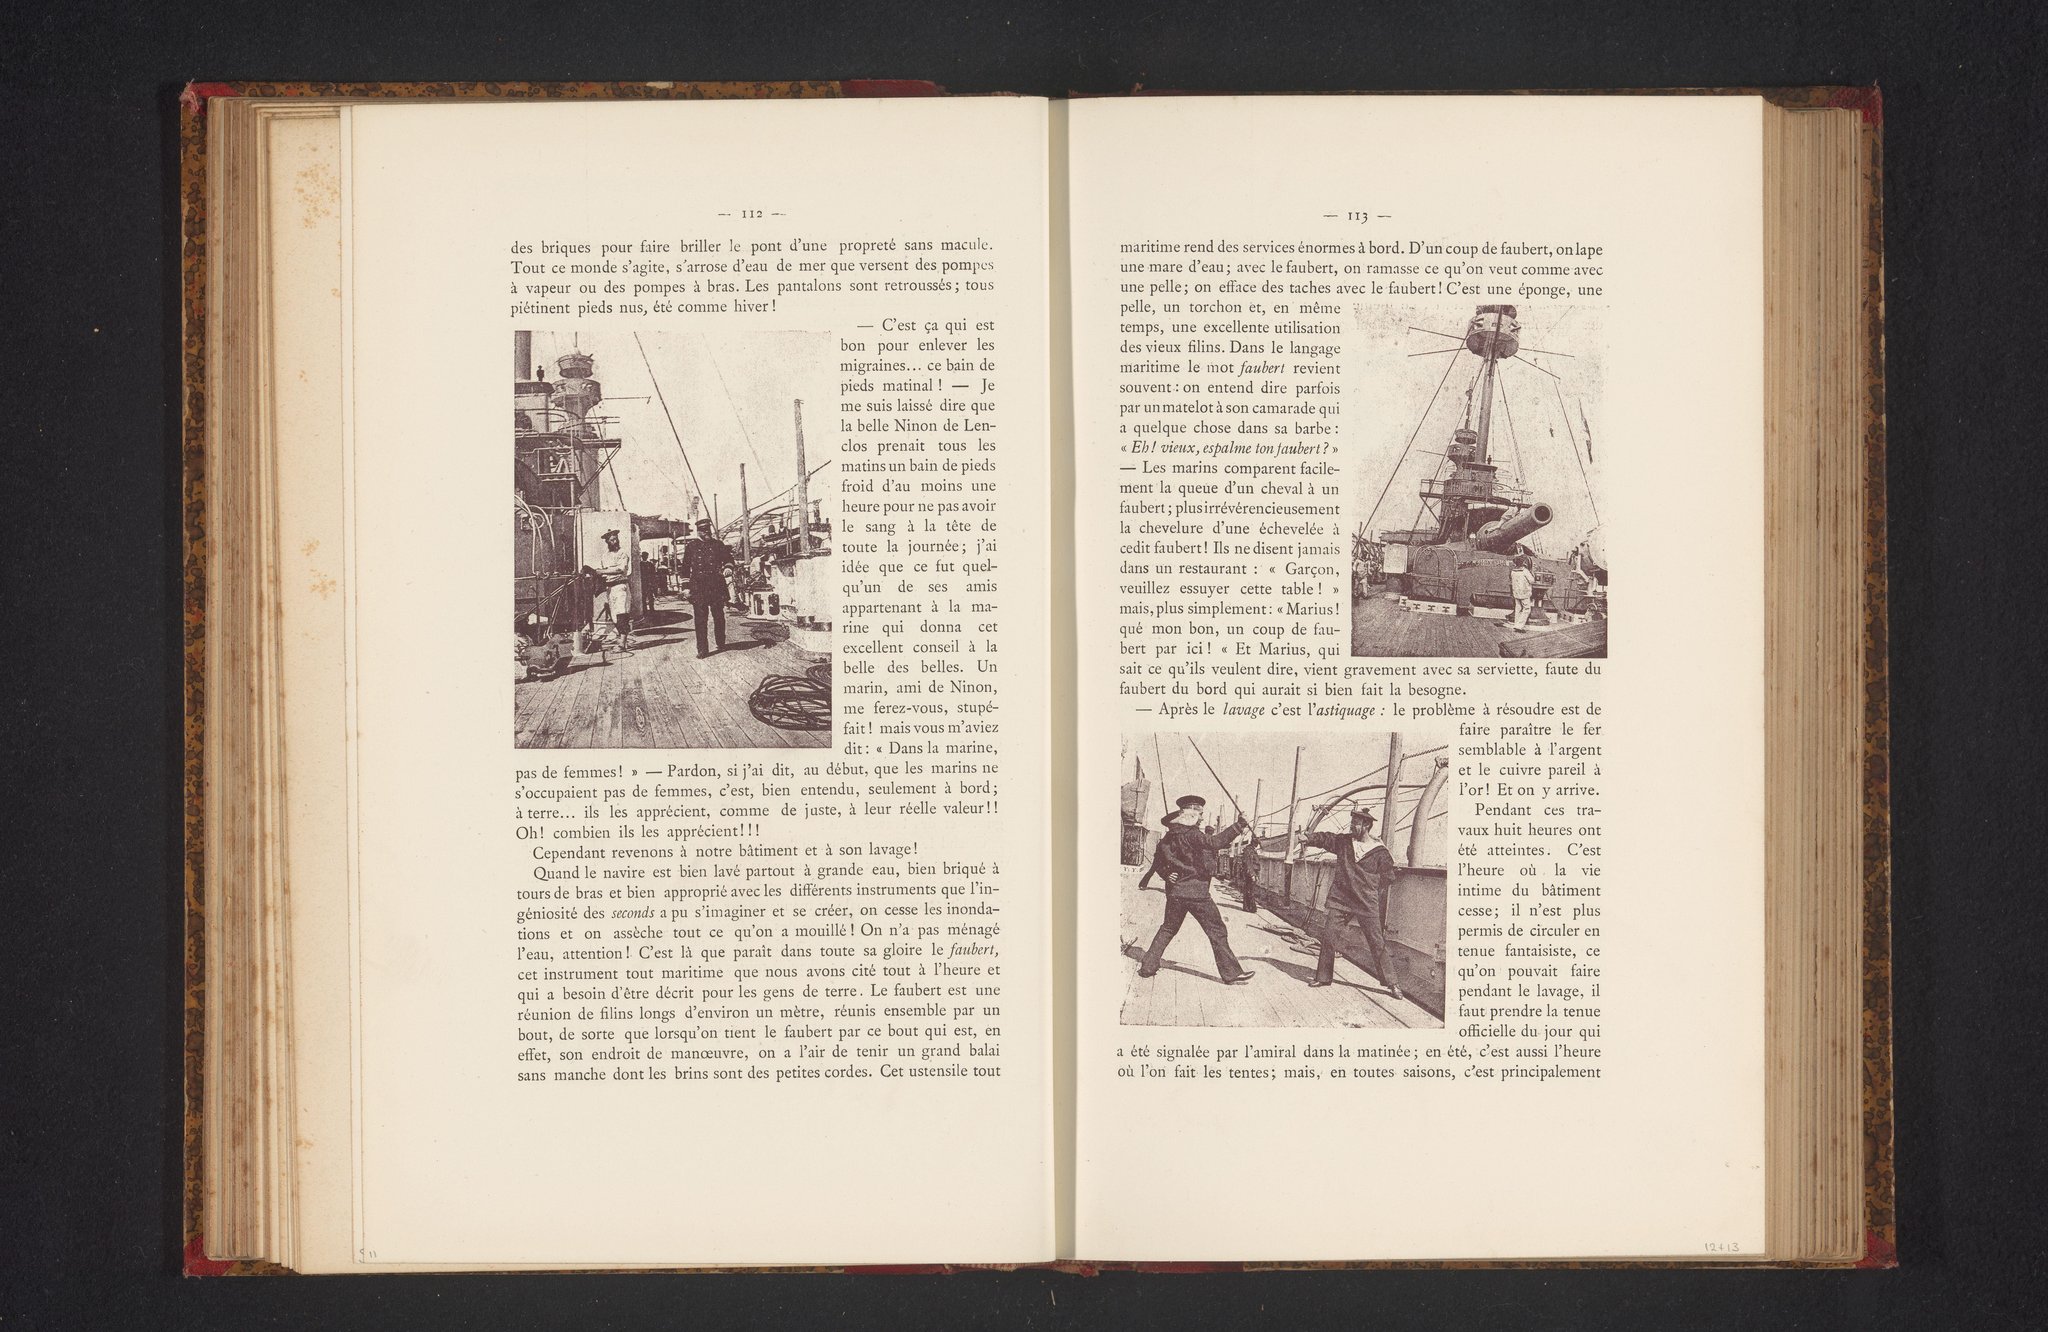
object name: photomechanical print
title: Matrozen houden een schermwedstrijd aan boord van een oorlogsschip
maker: Anonymous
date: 1888-1893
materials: paper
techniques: photograph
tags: crew ~ ship, sailor, fencing (sport), steamship, motorship